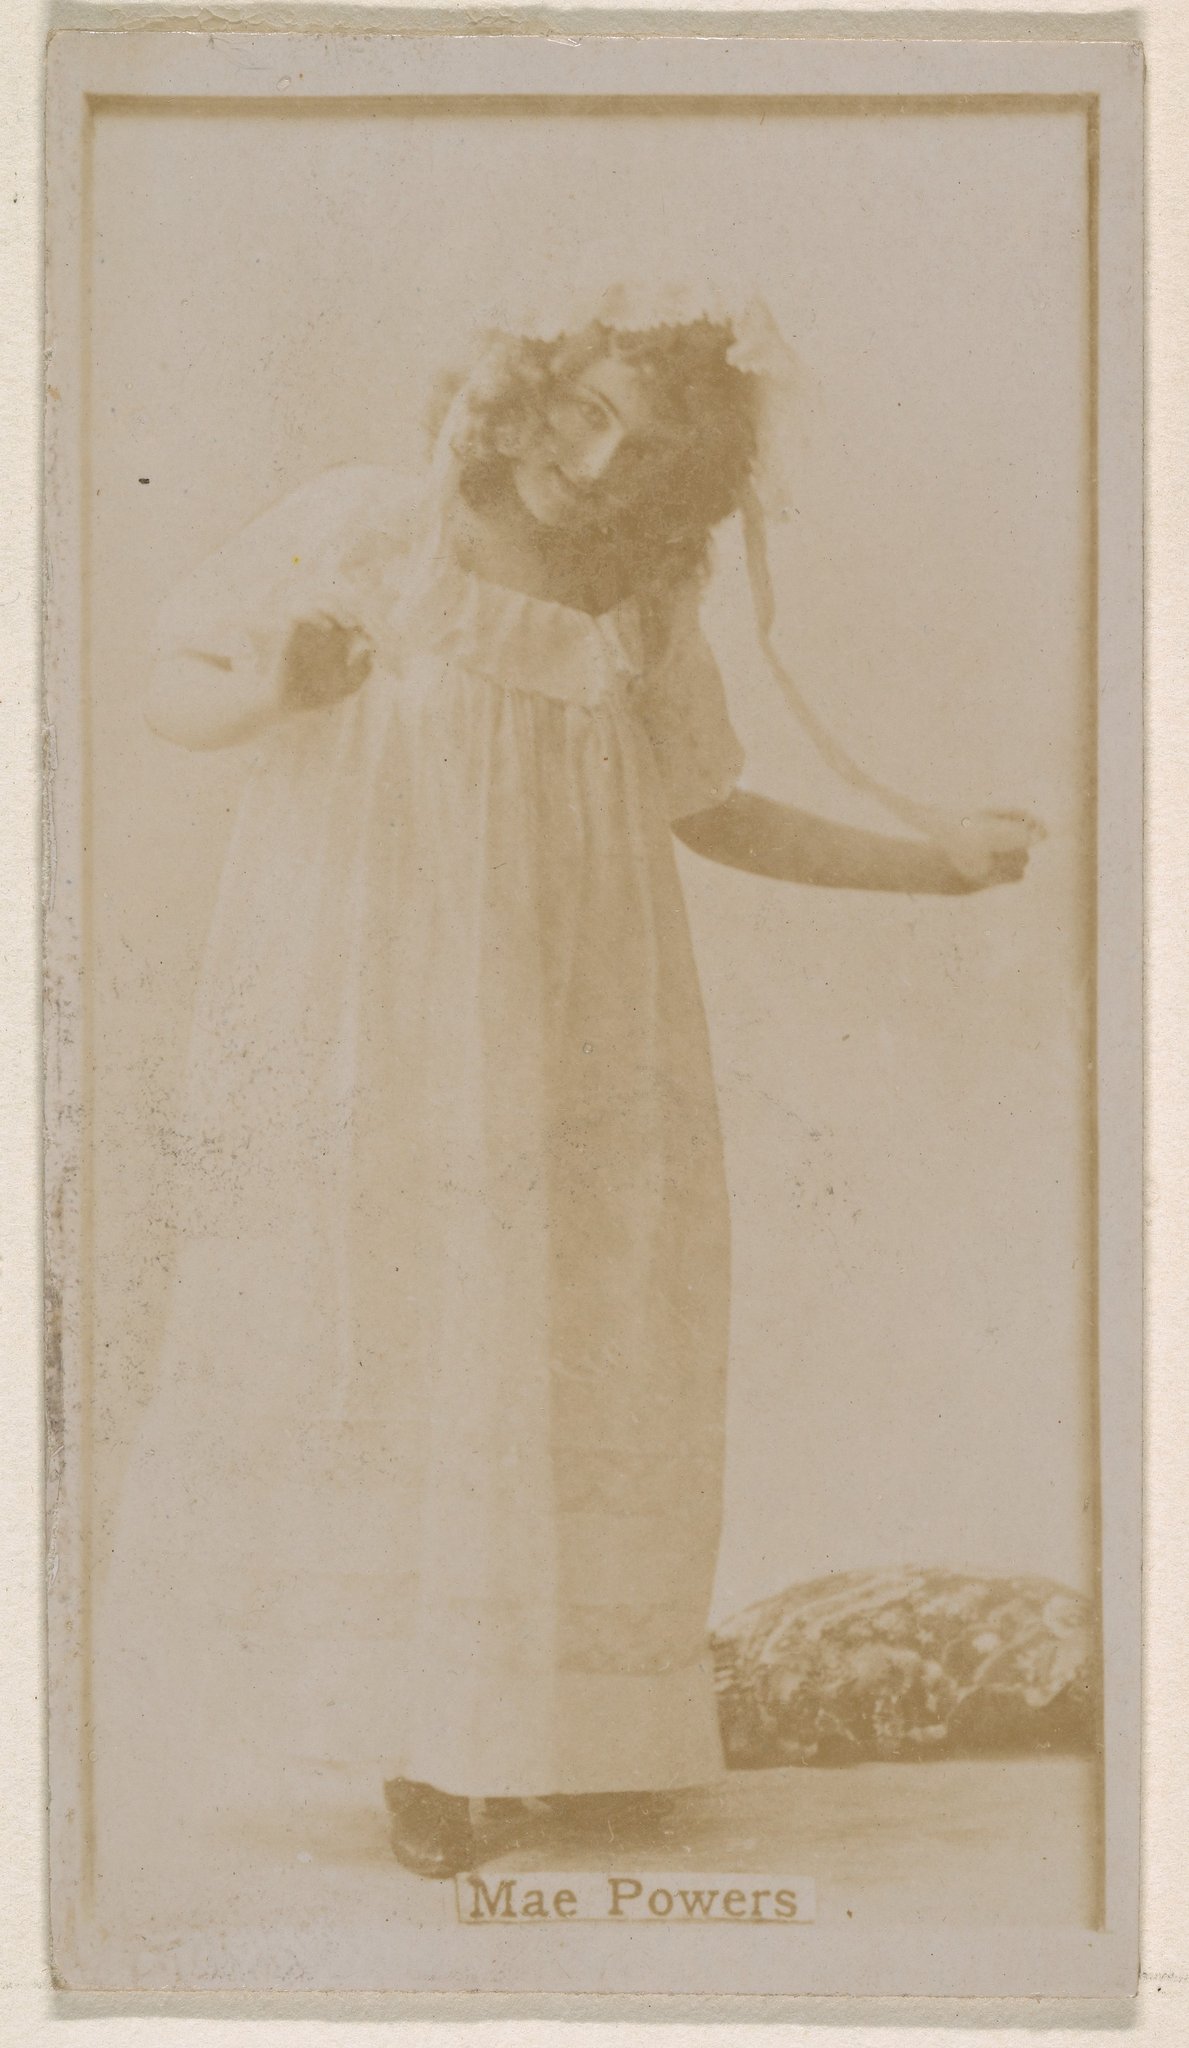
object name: photograph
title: Mae Powers, from the Actresses series (N245) issued by Kinney Brothers to promote Sweet Caporal Cigarettes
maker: kinney brothers tobacco company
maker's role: publisher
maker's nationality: american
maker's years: 1869-2011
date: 1890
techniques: albumen silver print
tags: portraits,women,actresses